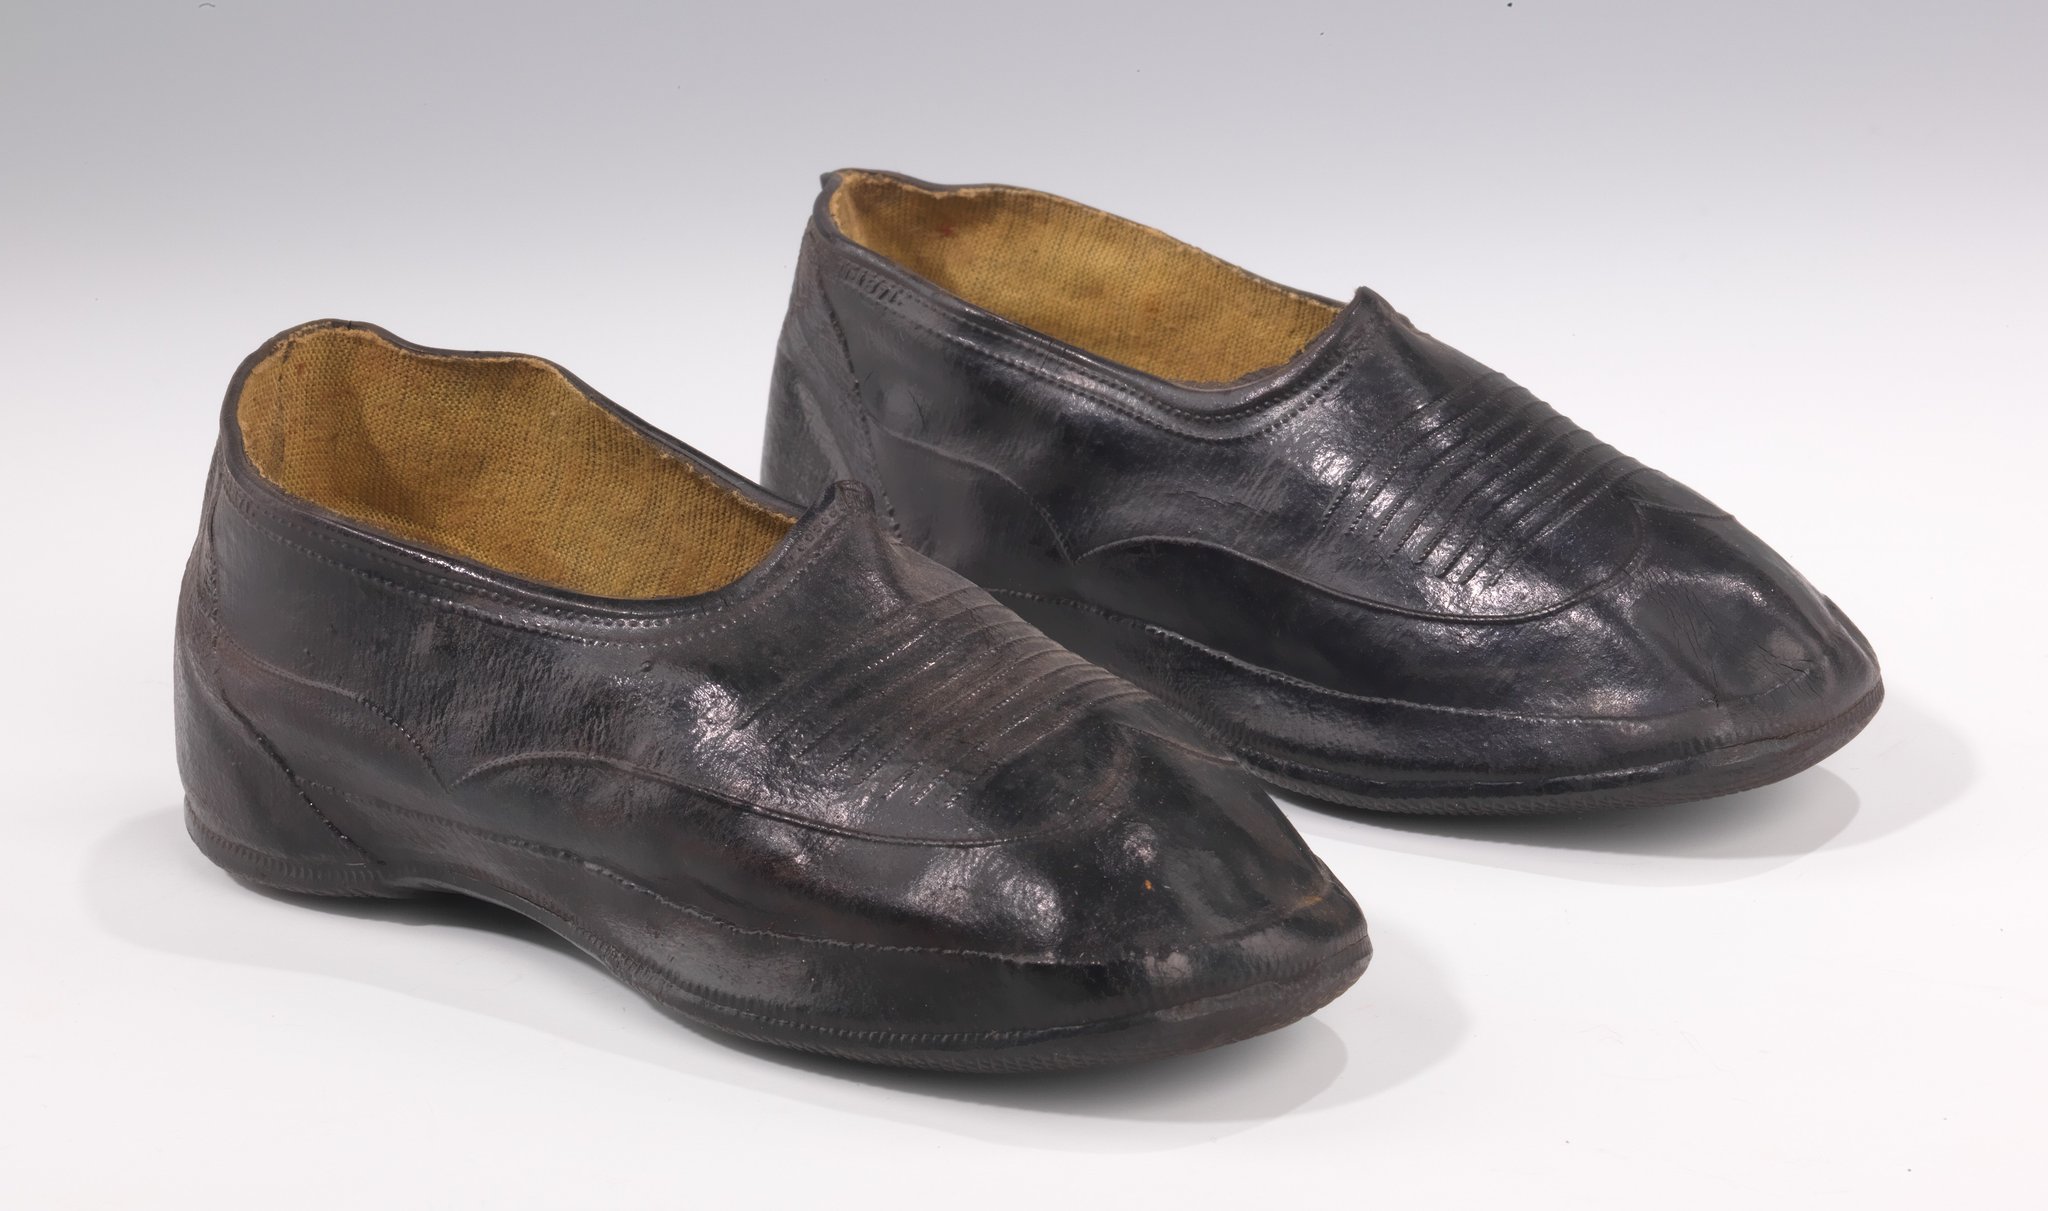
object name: galosh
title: Galoshes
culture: american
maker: meyer rubber company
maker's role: manufacturer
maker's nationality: american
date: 1886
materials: rubber